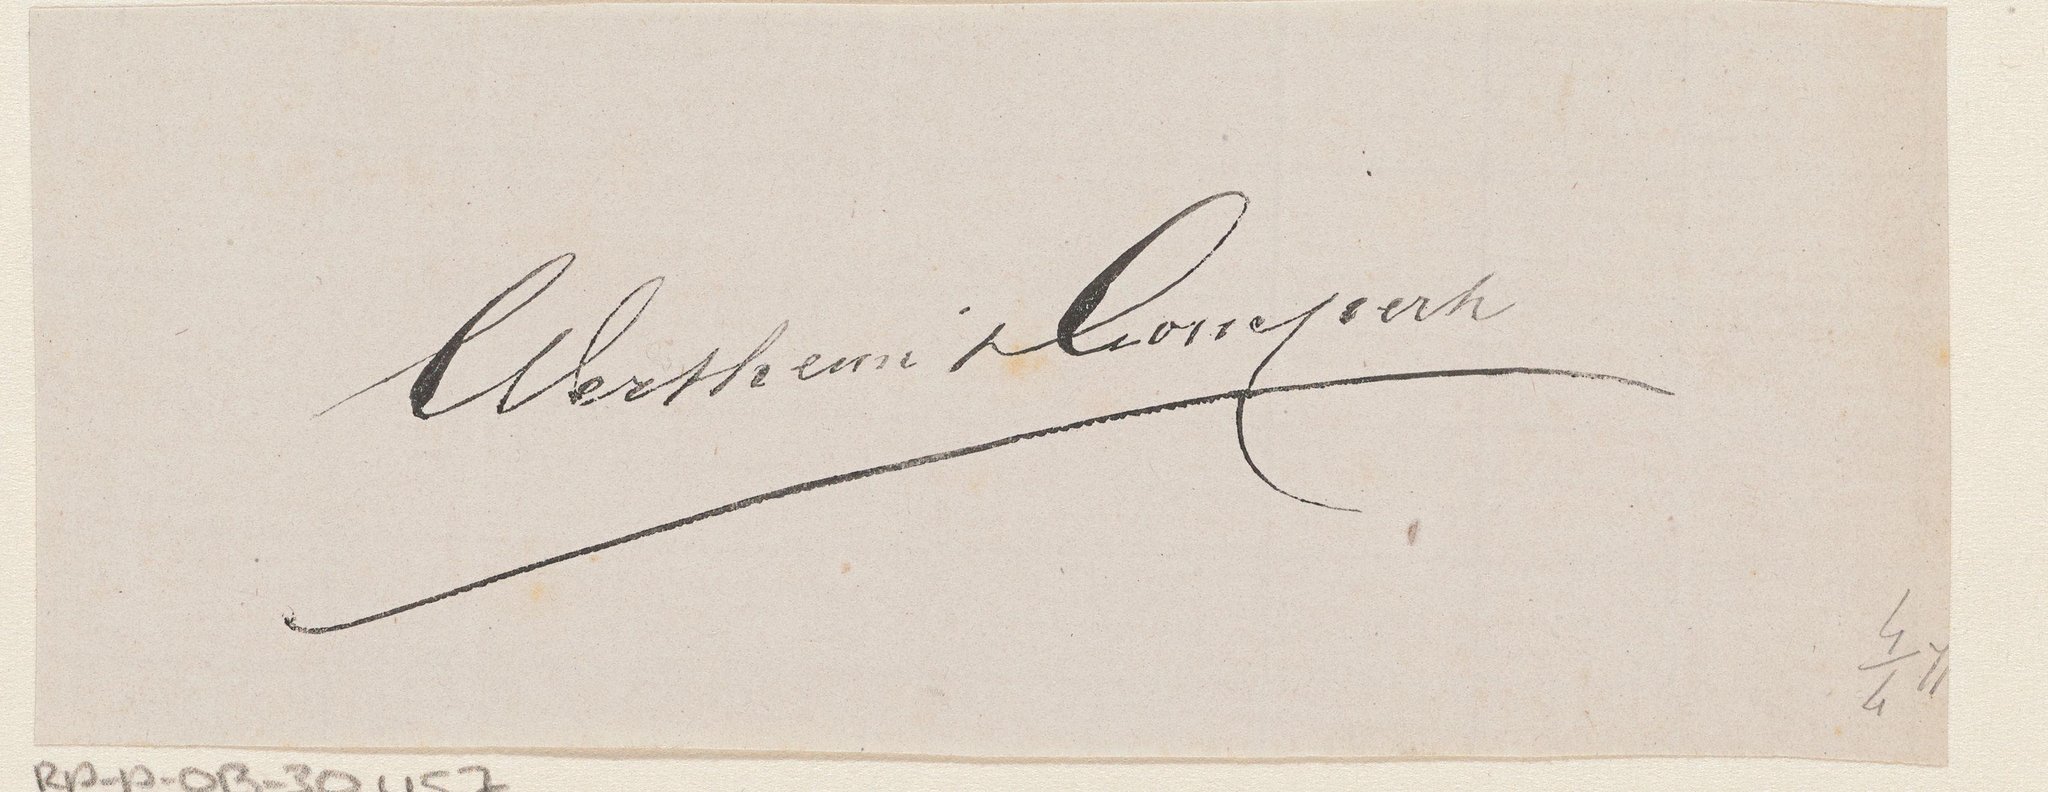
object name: print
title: Handtekening van een bankier (mogelijk Abraham Carel Wertheim) van de bank Lippmann, Rosenthal & Comp. te Amsterdam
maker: isaac weissenbruch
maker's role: print maker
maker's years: 1826-1912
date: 1859-1912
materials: paper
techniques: engraving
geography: netherlands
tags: banker, bank